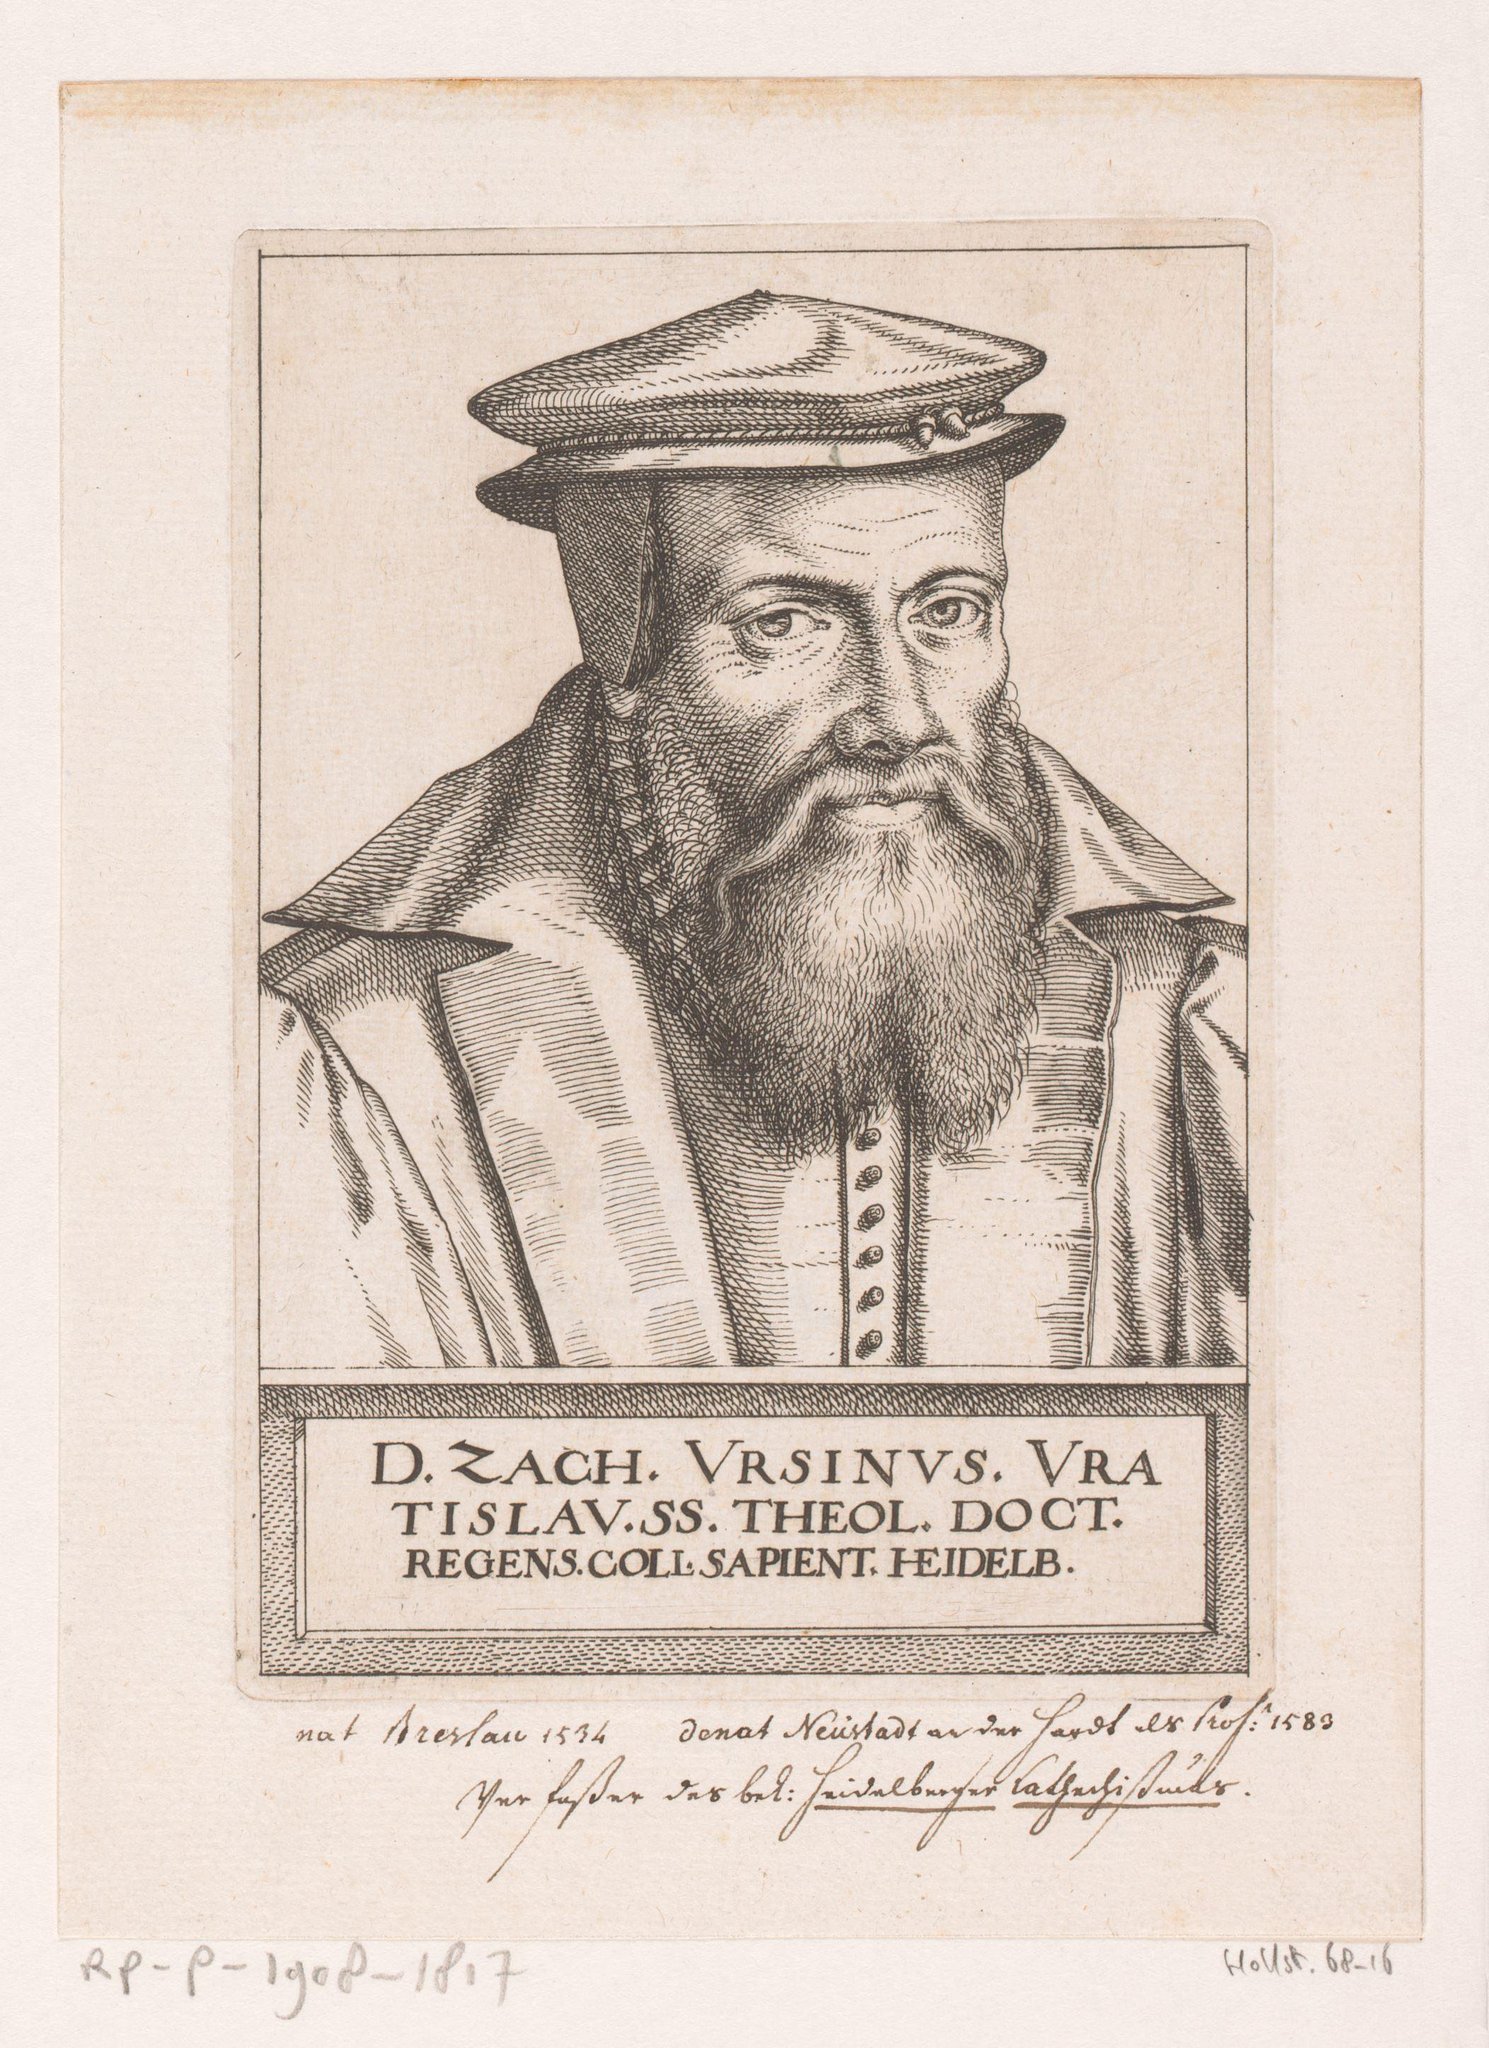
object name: print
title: Portret van Zacharias Ursinus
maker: dietrich meyer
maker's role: painter, print maker, publisher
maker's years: 1572-1658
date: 1582-1658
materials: paper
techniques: engraving, etching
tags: theologian, historical persons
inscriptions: collector's mark: Lugt 2228